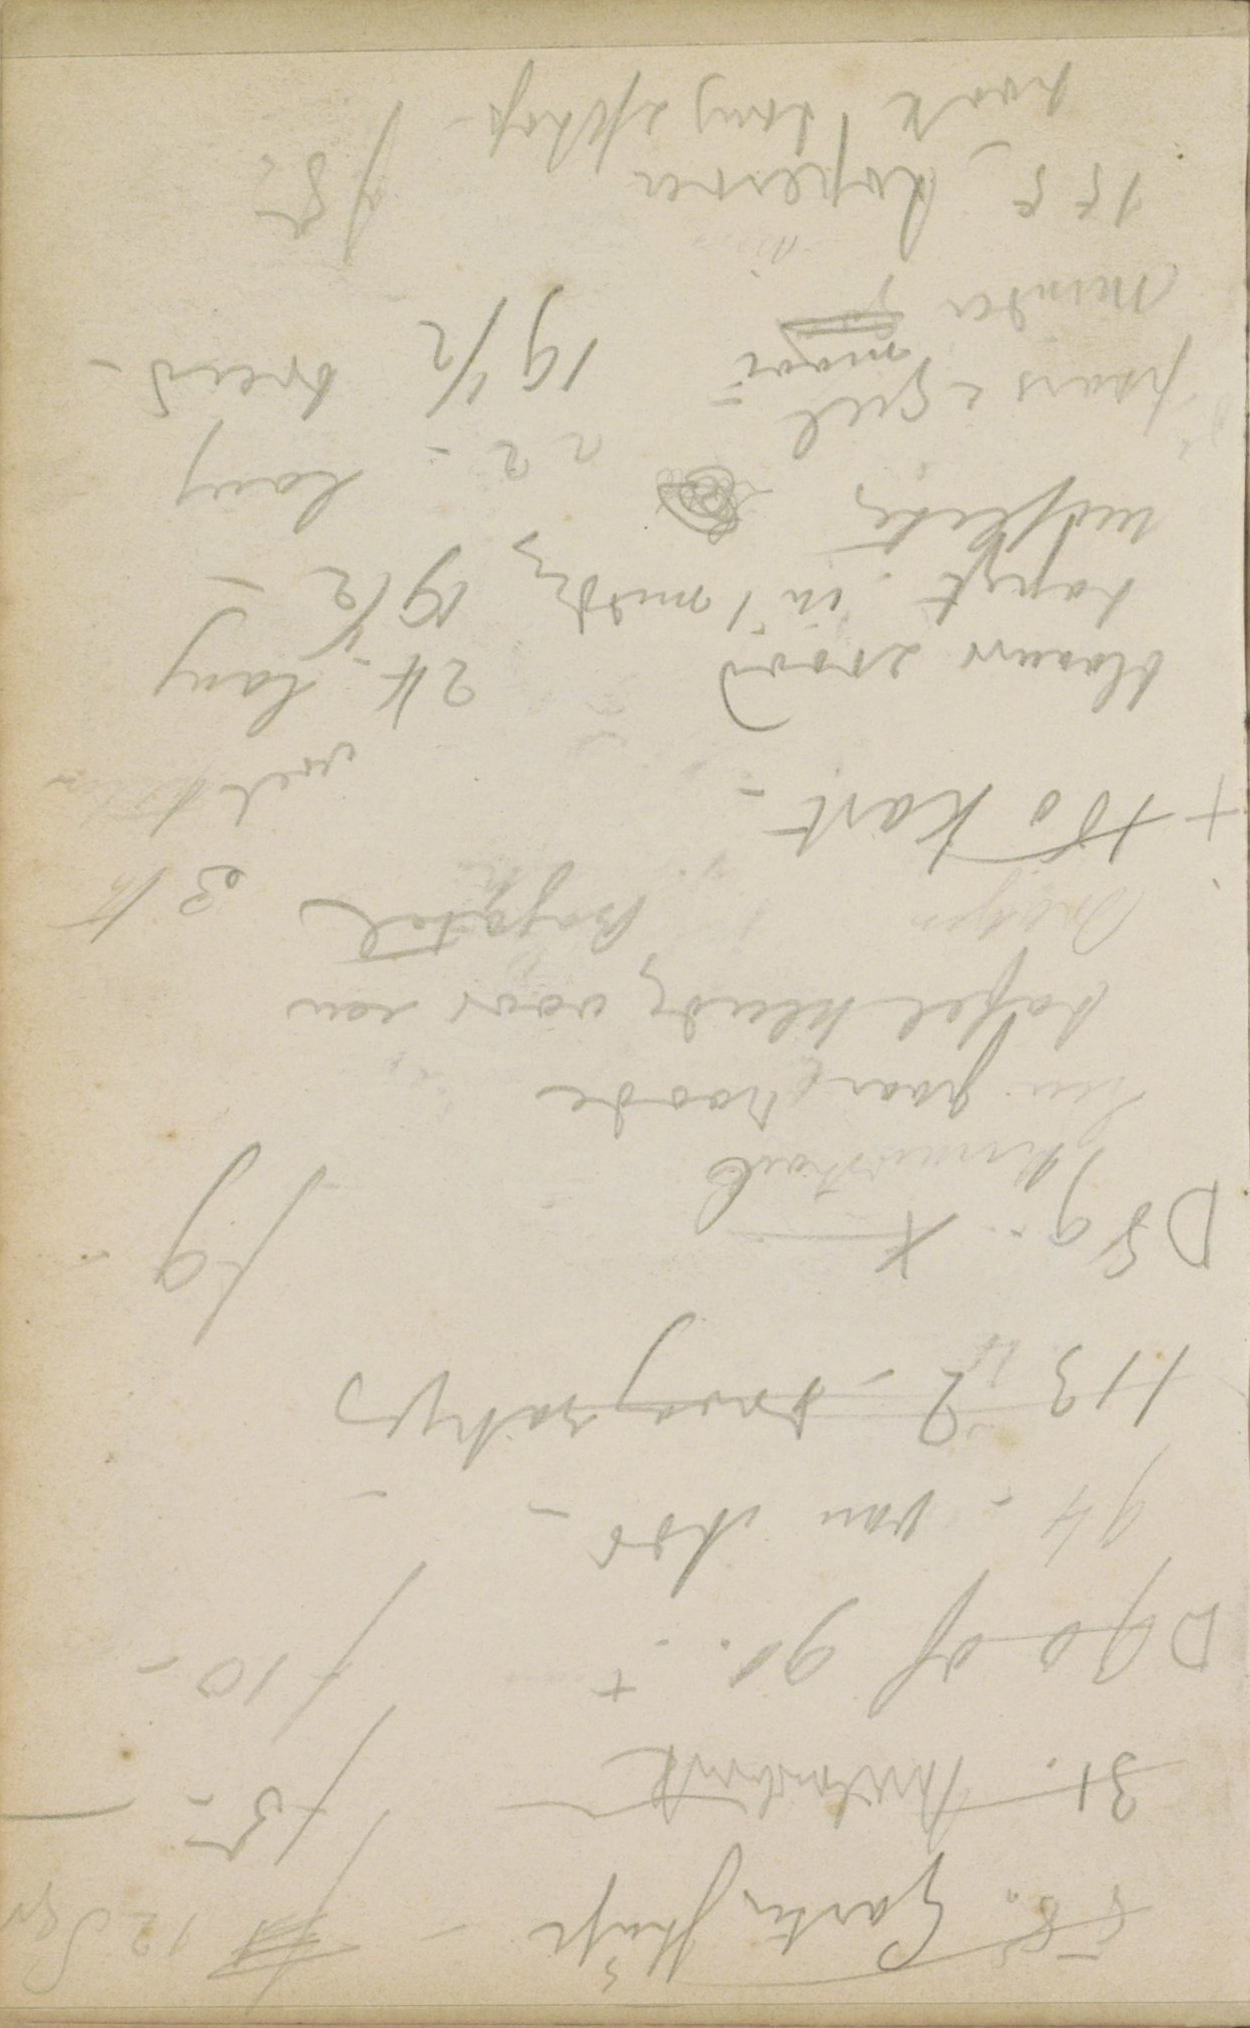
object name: sketchbook leaf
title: Notities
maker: johannes tavenraat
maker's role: draughtsman, painter, print maker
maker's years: 1809-1881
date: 1839-1872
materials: paper, pencil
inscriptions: annotation: ‘[...]’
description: Blad 46 verso uit een schetsboek met 73 bladen.